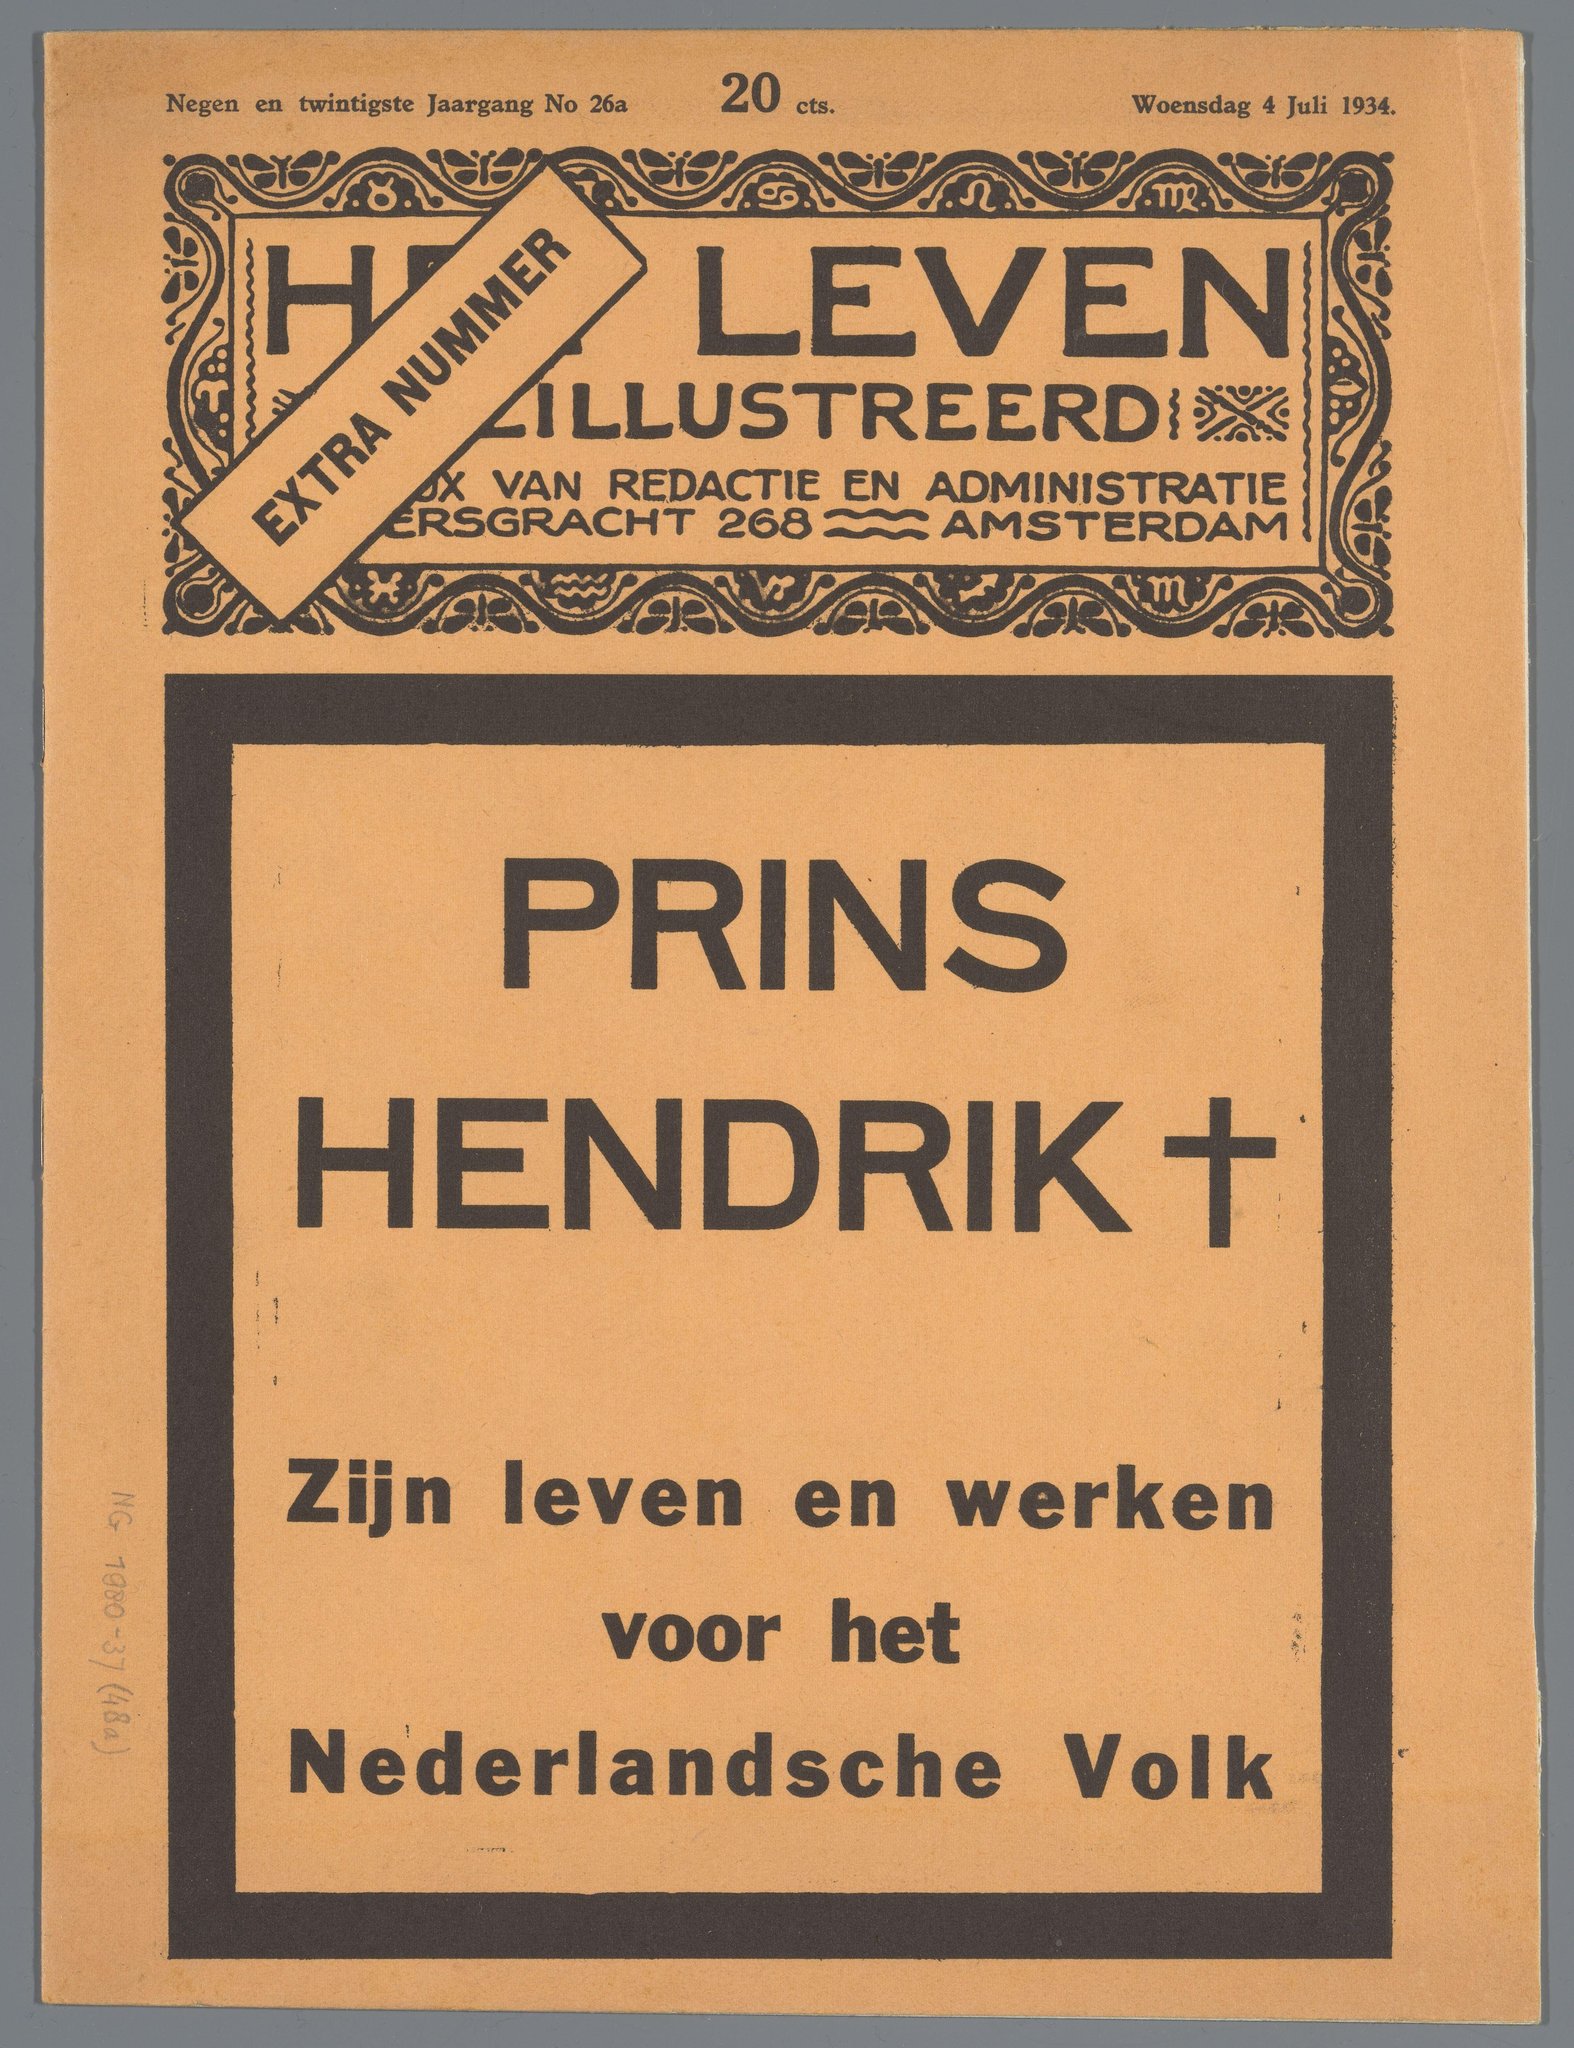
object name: newspaper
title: Het Leven geillustreerd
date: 1934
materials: paper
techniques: printing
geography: amsterdam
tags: the hague, hendrik (prins der nederlanden (1876-1934)), netherlands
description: Tijdschrift over het overlijden van prins Hendrik, nr. 26a van de 29e jaargang van 'Het Leven', 16 niet genummerde pp in een lichtbruine dikpapieren omslag; tal van fotos.